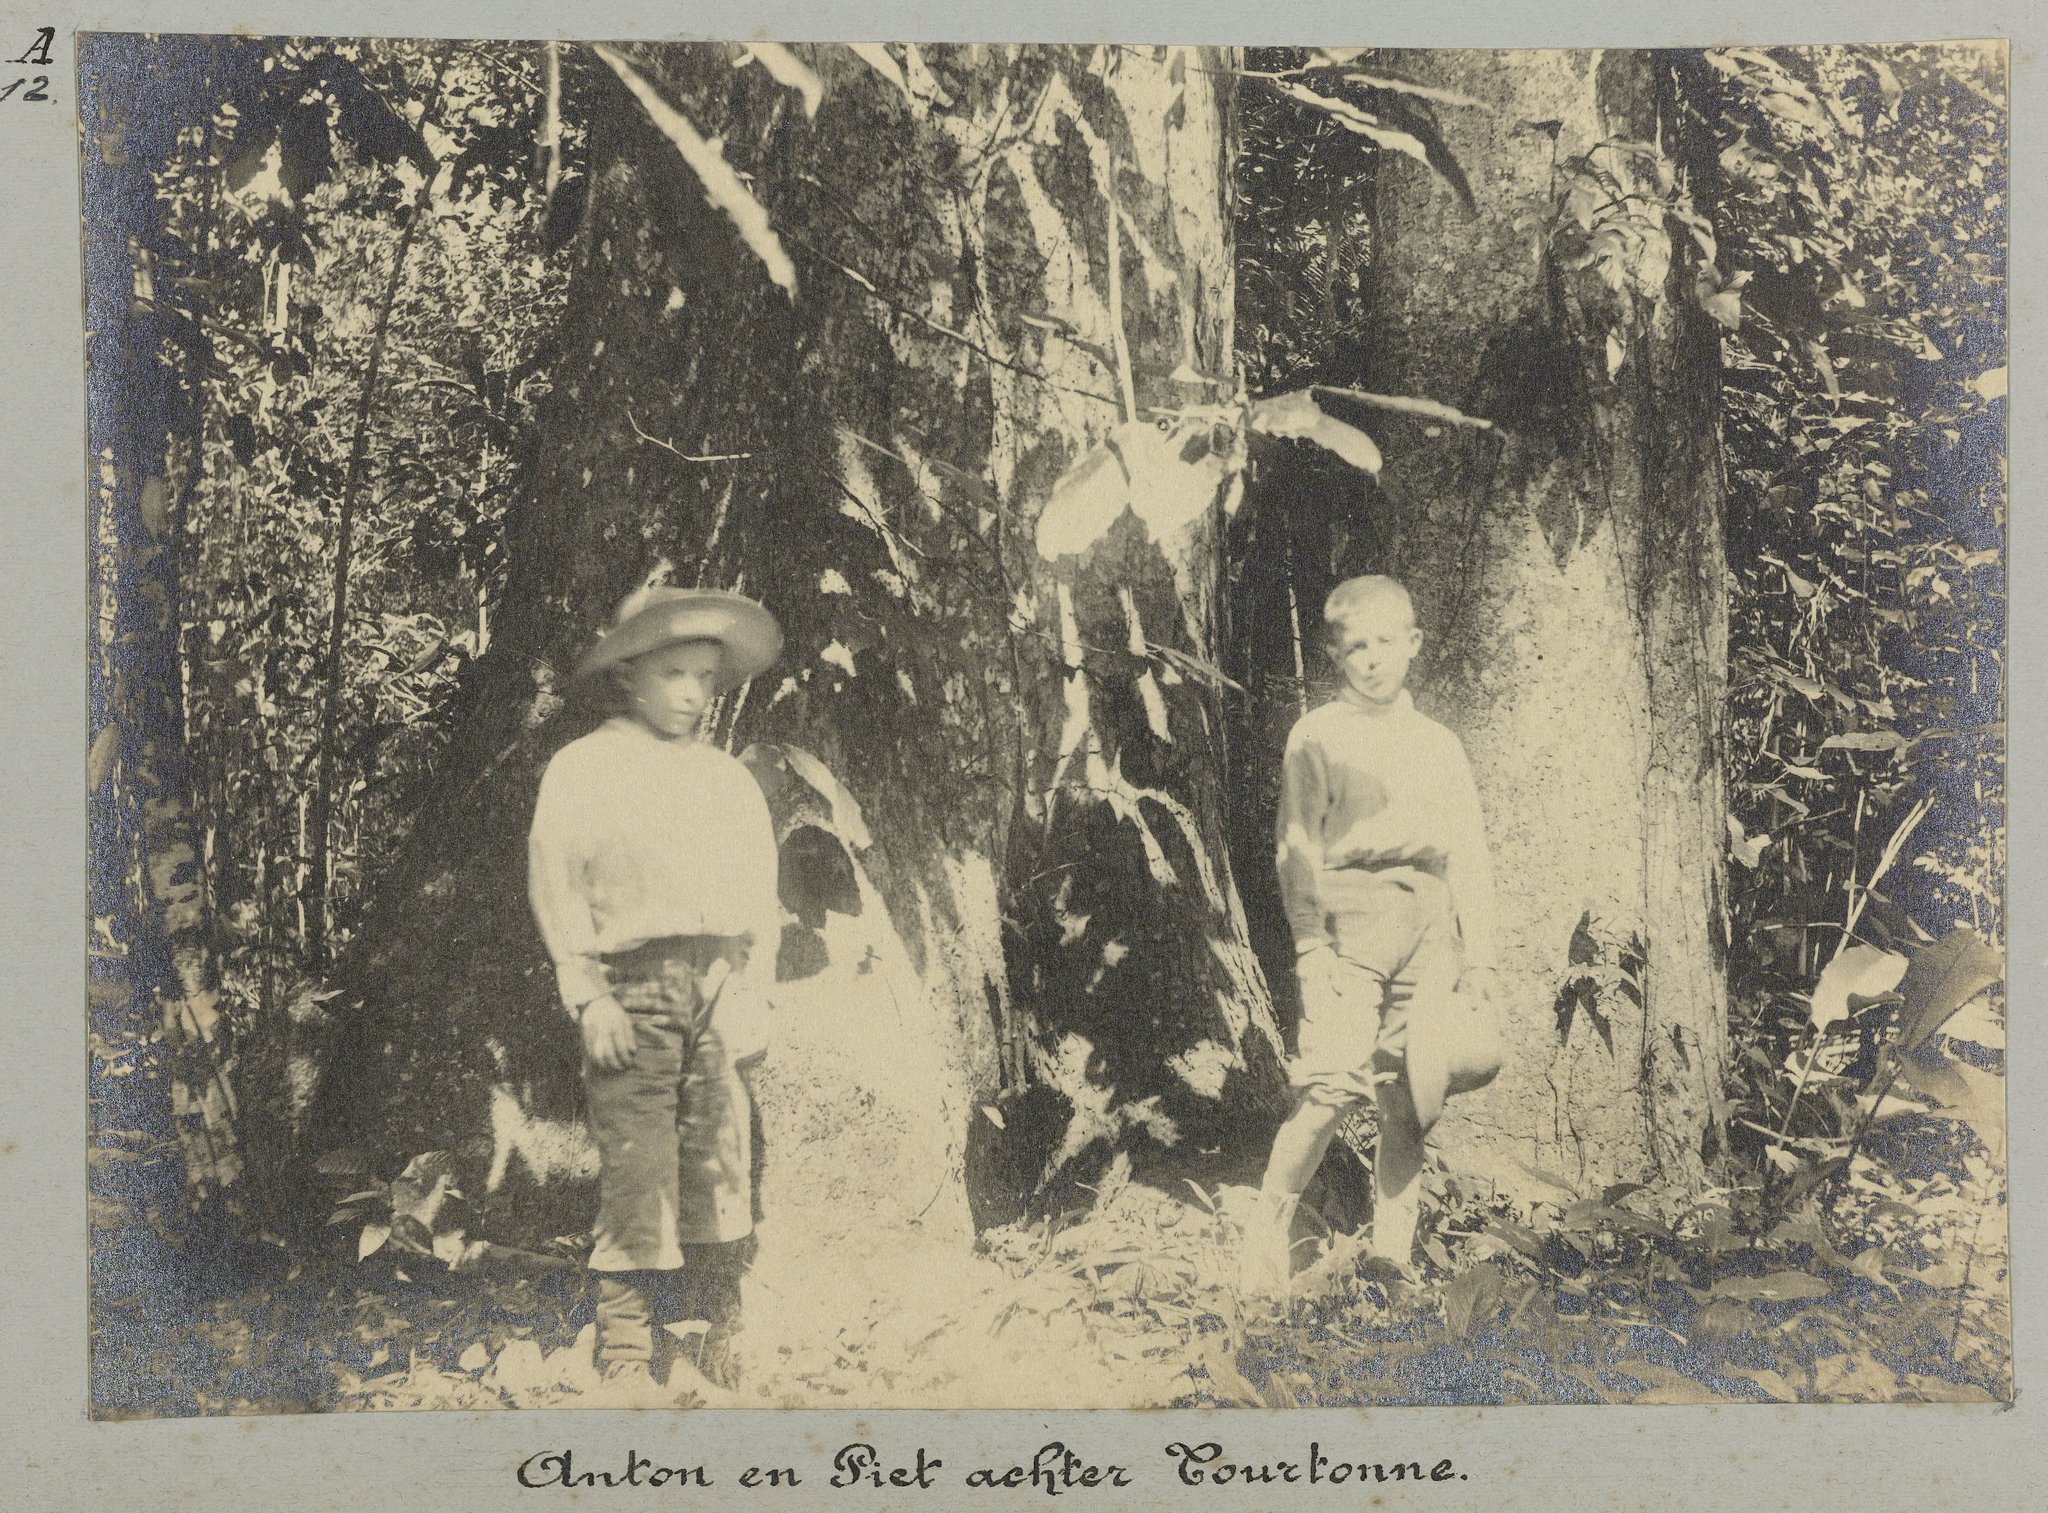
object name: photograph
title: Anton en Piet achter Tourtonne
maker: hendrik doijer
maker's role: engineer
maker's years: 1863-1925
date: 1903-1910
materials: photographic support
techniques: gelatin silver print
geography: suriname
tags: suriname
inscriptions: inscription: ‘A12. / Anton en Piet achter Tourtonne.’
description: Twee jongens genaamd Anton en Piet staande voor bomen achter de plantage Tourtonne. Onderdeel van het fotoalbum Souvenir de Voyage (deel 1), over het leven van de familie Doijer in en rond de plantage Ma Retraite in Suriname in de jaren 1903-1910.